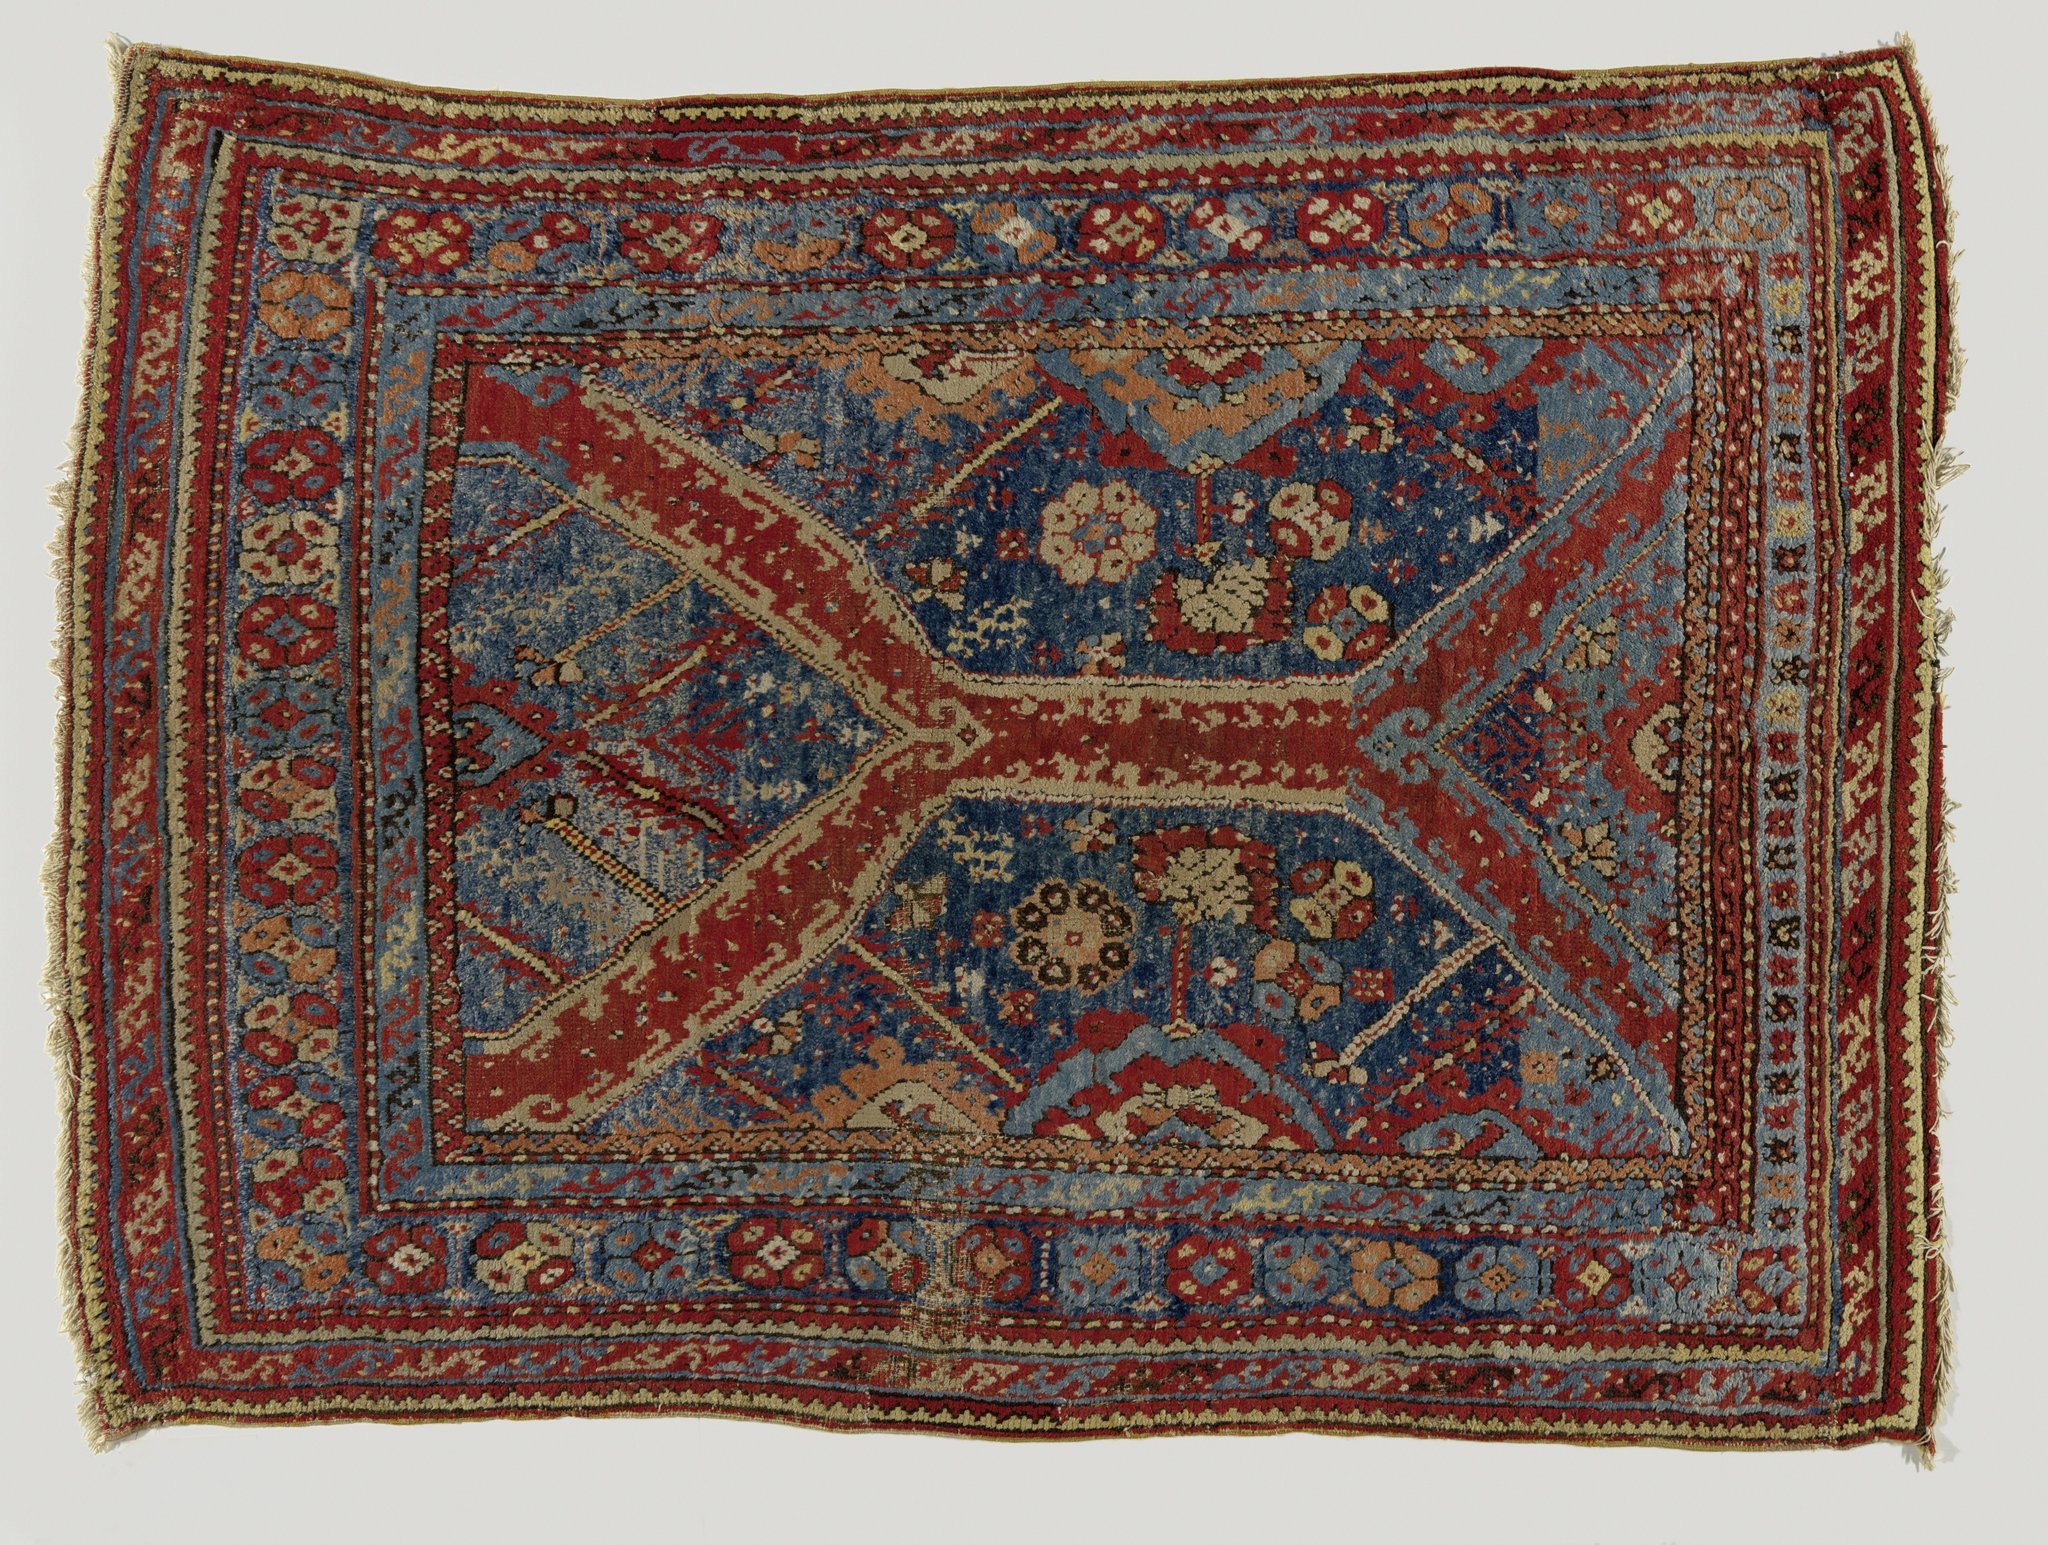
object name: medaillonkleed, medaillontapijt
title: Medaillonkleed, type USHAK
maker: Anonymous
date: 1900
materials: wool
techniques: ghiordes knot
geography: ushak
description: Medaillonkleed, type USHAK. Middenveld: op een helderrode fond staan vier grote halve zeshoekige medaillons dicht op elkaar in ultramarijnblauw met vaalgele contouren. De zijmedaillons zijn gevuld met een lichtblauwe ruit en zalmkleurige palmetten in de toppen. De onderste en bovenste medaillons zijn gehalveerde ruiten in rood met schuine lijnen en stengels. Op het fond staan palmet- en rozetbloemen in rood, wit en zwart. Rand: veelvoudig. De middelste van blauw met kwartrozetten in rood, wit, lichtblauw, zalmkleur en geel. Binnenzoom in blauw en buitenzoom in rood, met gelijke S-sen in gemelde kleuren. Opmerking: vermoedelijk Engeland, axminster of Wilton? Of Klein-Azië, Ushak.